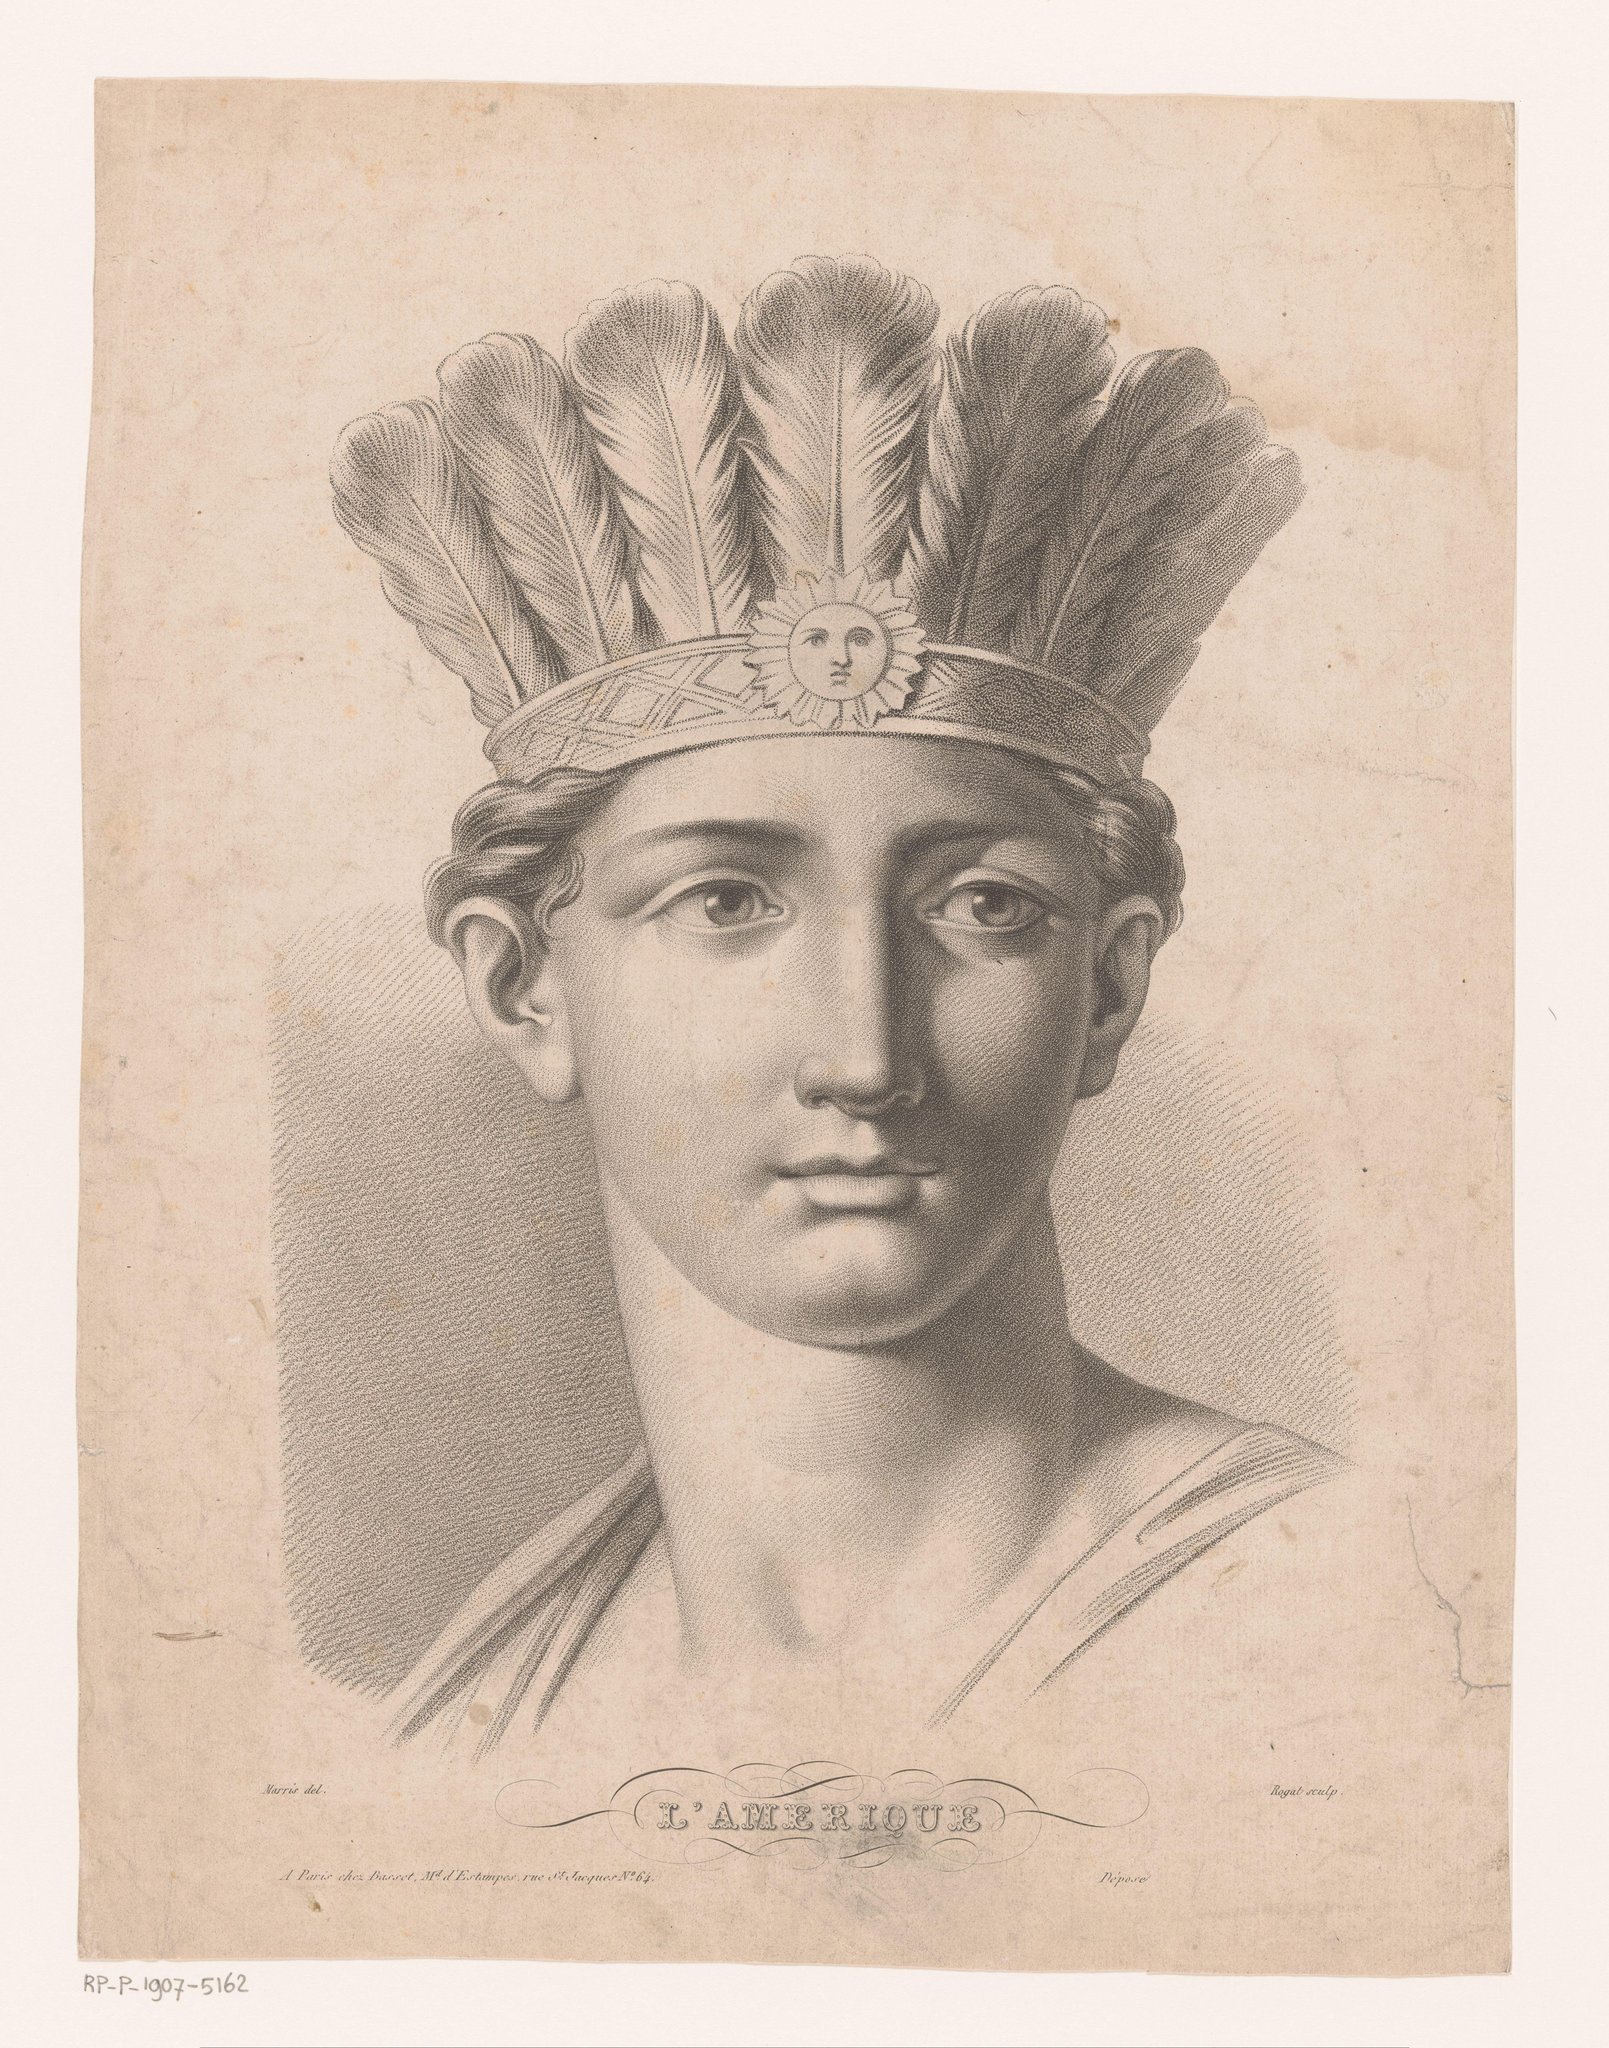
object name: print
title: L'Amerique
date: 1785-1830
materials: paper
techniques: stippling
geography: paris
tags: personifications of countries, nations, states, districts, etc., indigenous peoples of north america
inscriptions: : ‘Déposé’, collector's mark: Lugt 2228